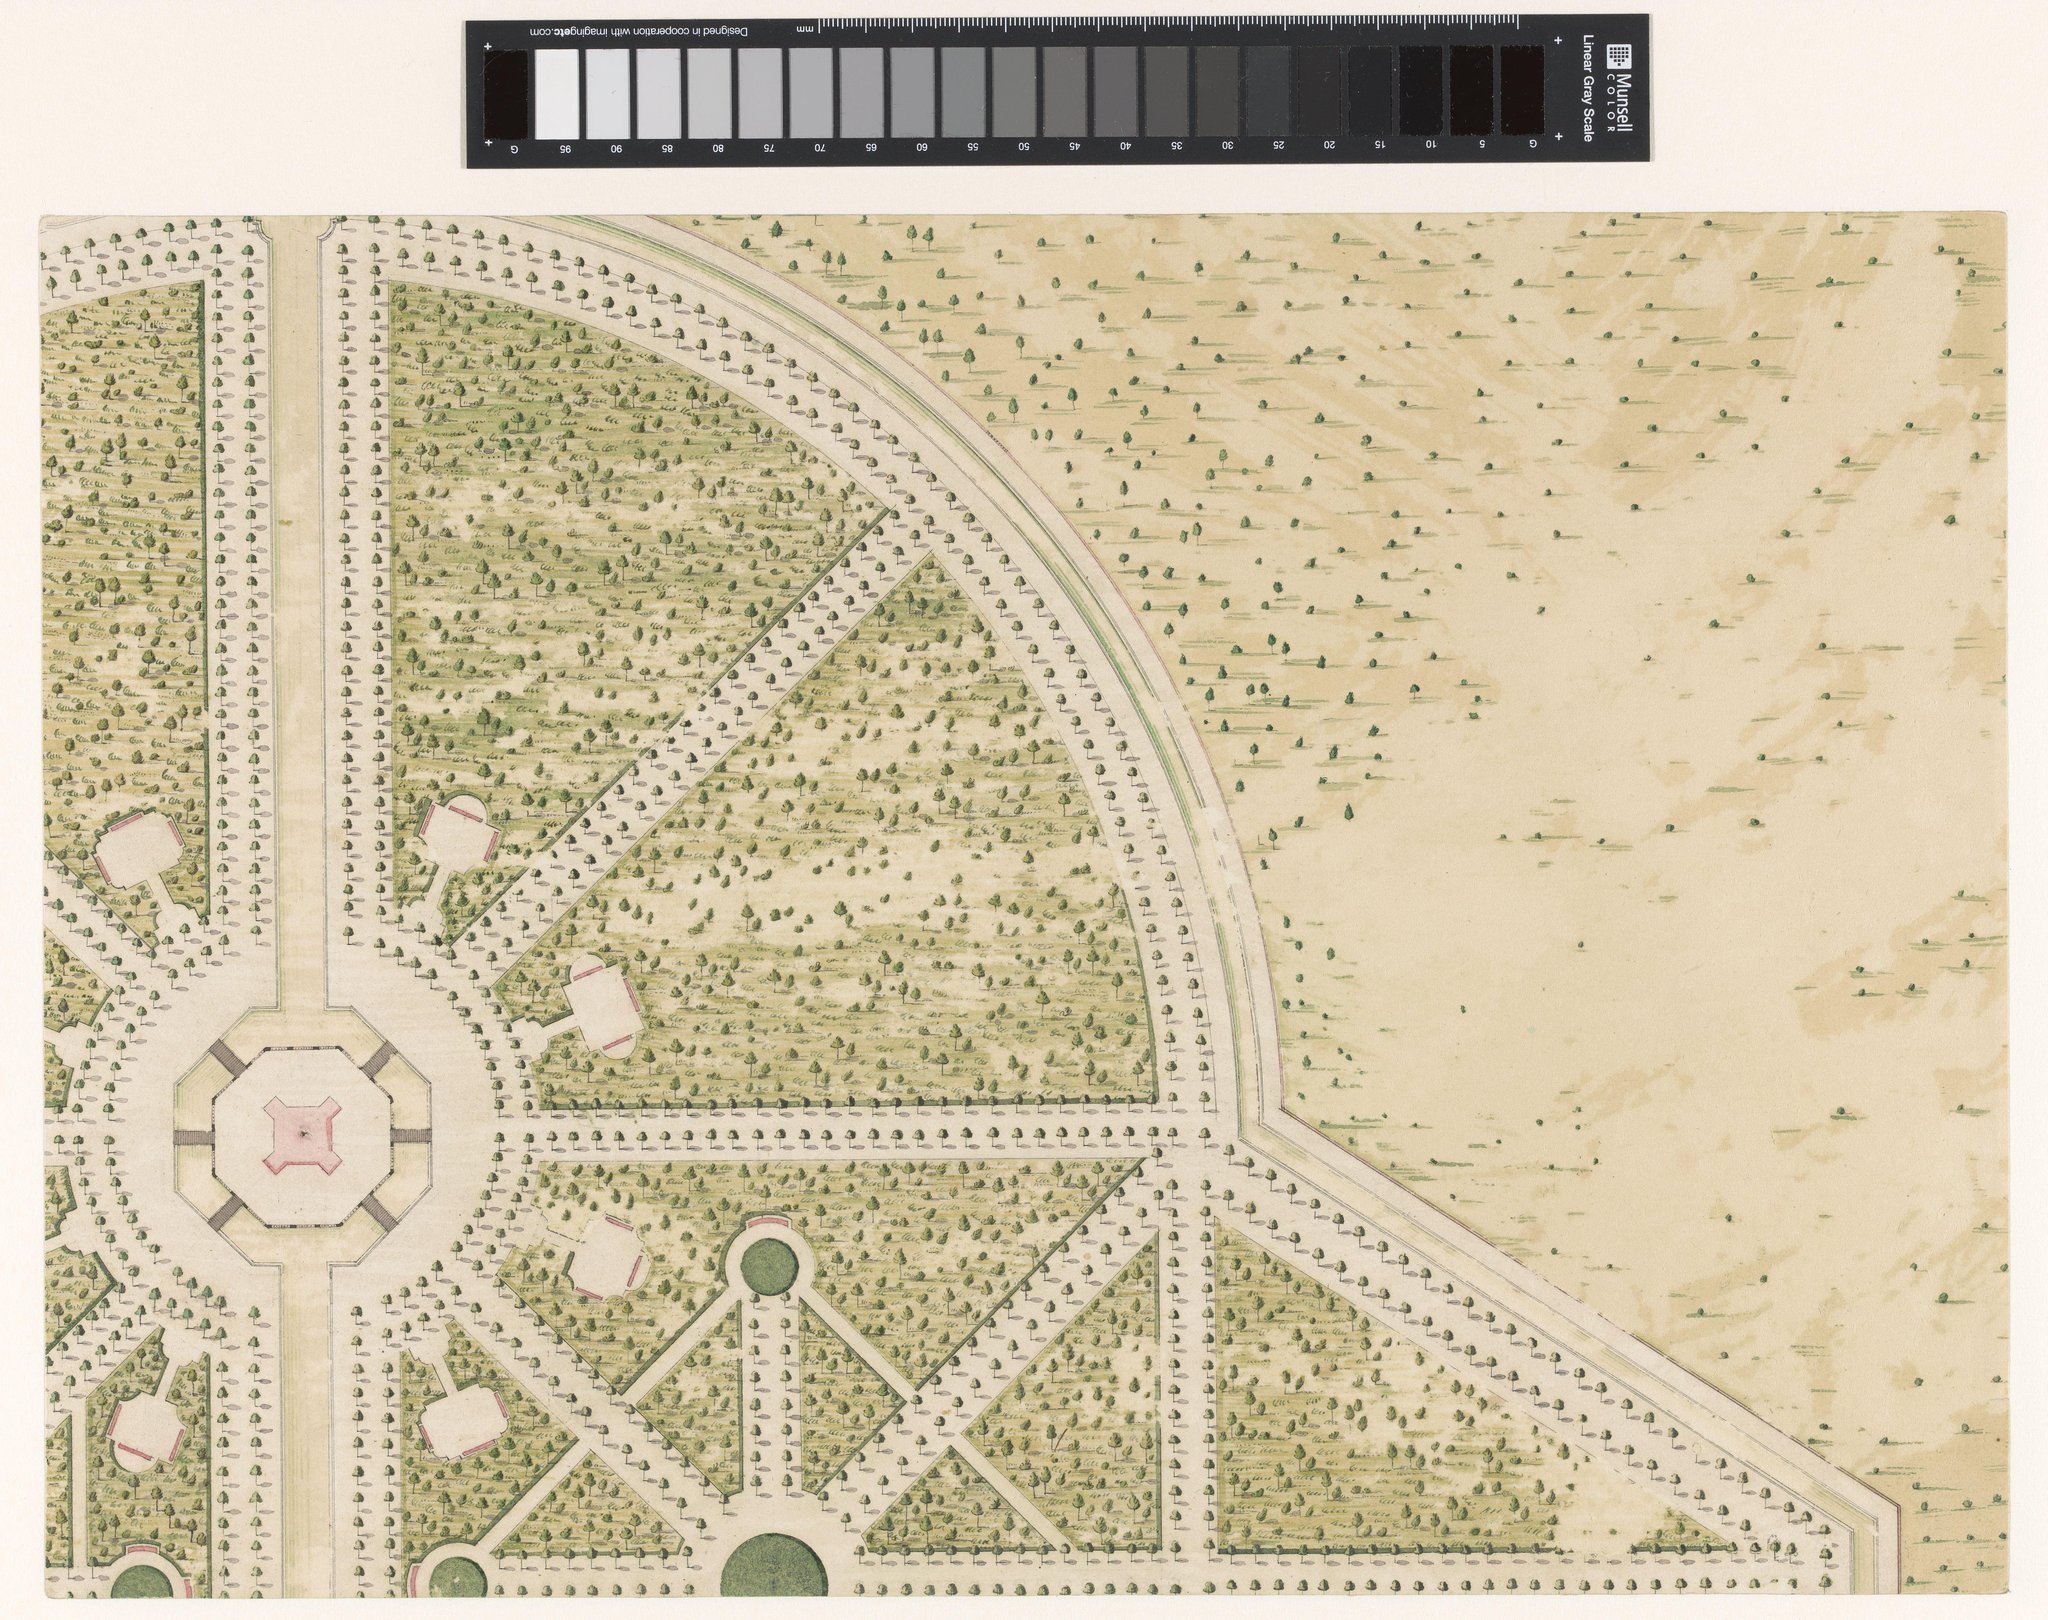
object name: design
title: Gedeelte van een plattegrond met tuinaanleg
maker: Anonymous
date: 1700-1725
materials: ink, paper, pencil, watercolor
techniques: brush, pen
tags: lay-out of garden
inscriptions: annotation, verso, lower left, pencil: ‘2 [omcirkeld]’, annotation, verso, lower right, pen and ink: ‘Italian 16th cent’, annotation, verso, lower right, pencil: ‘O. 7. ob’